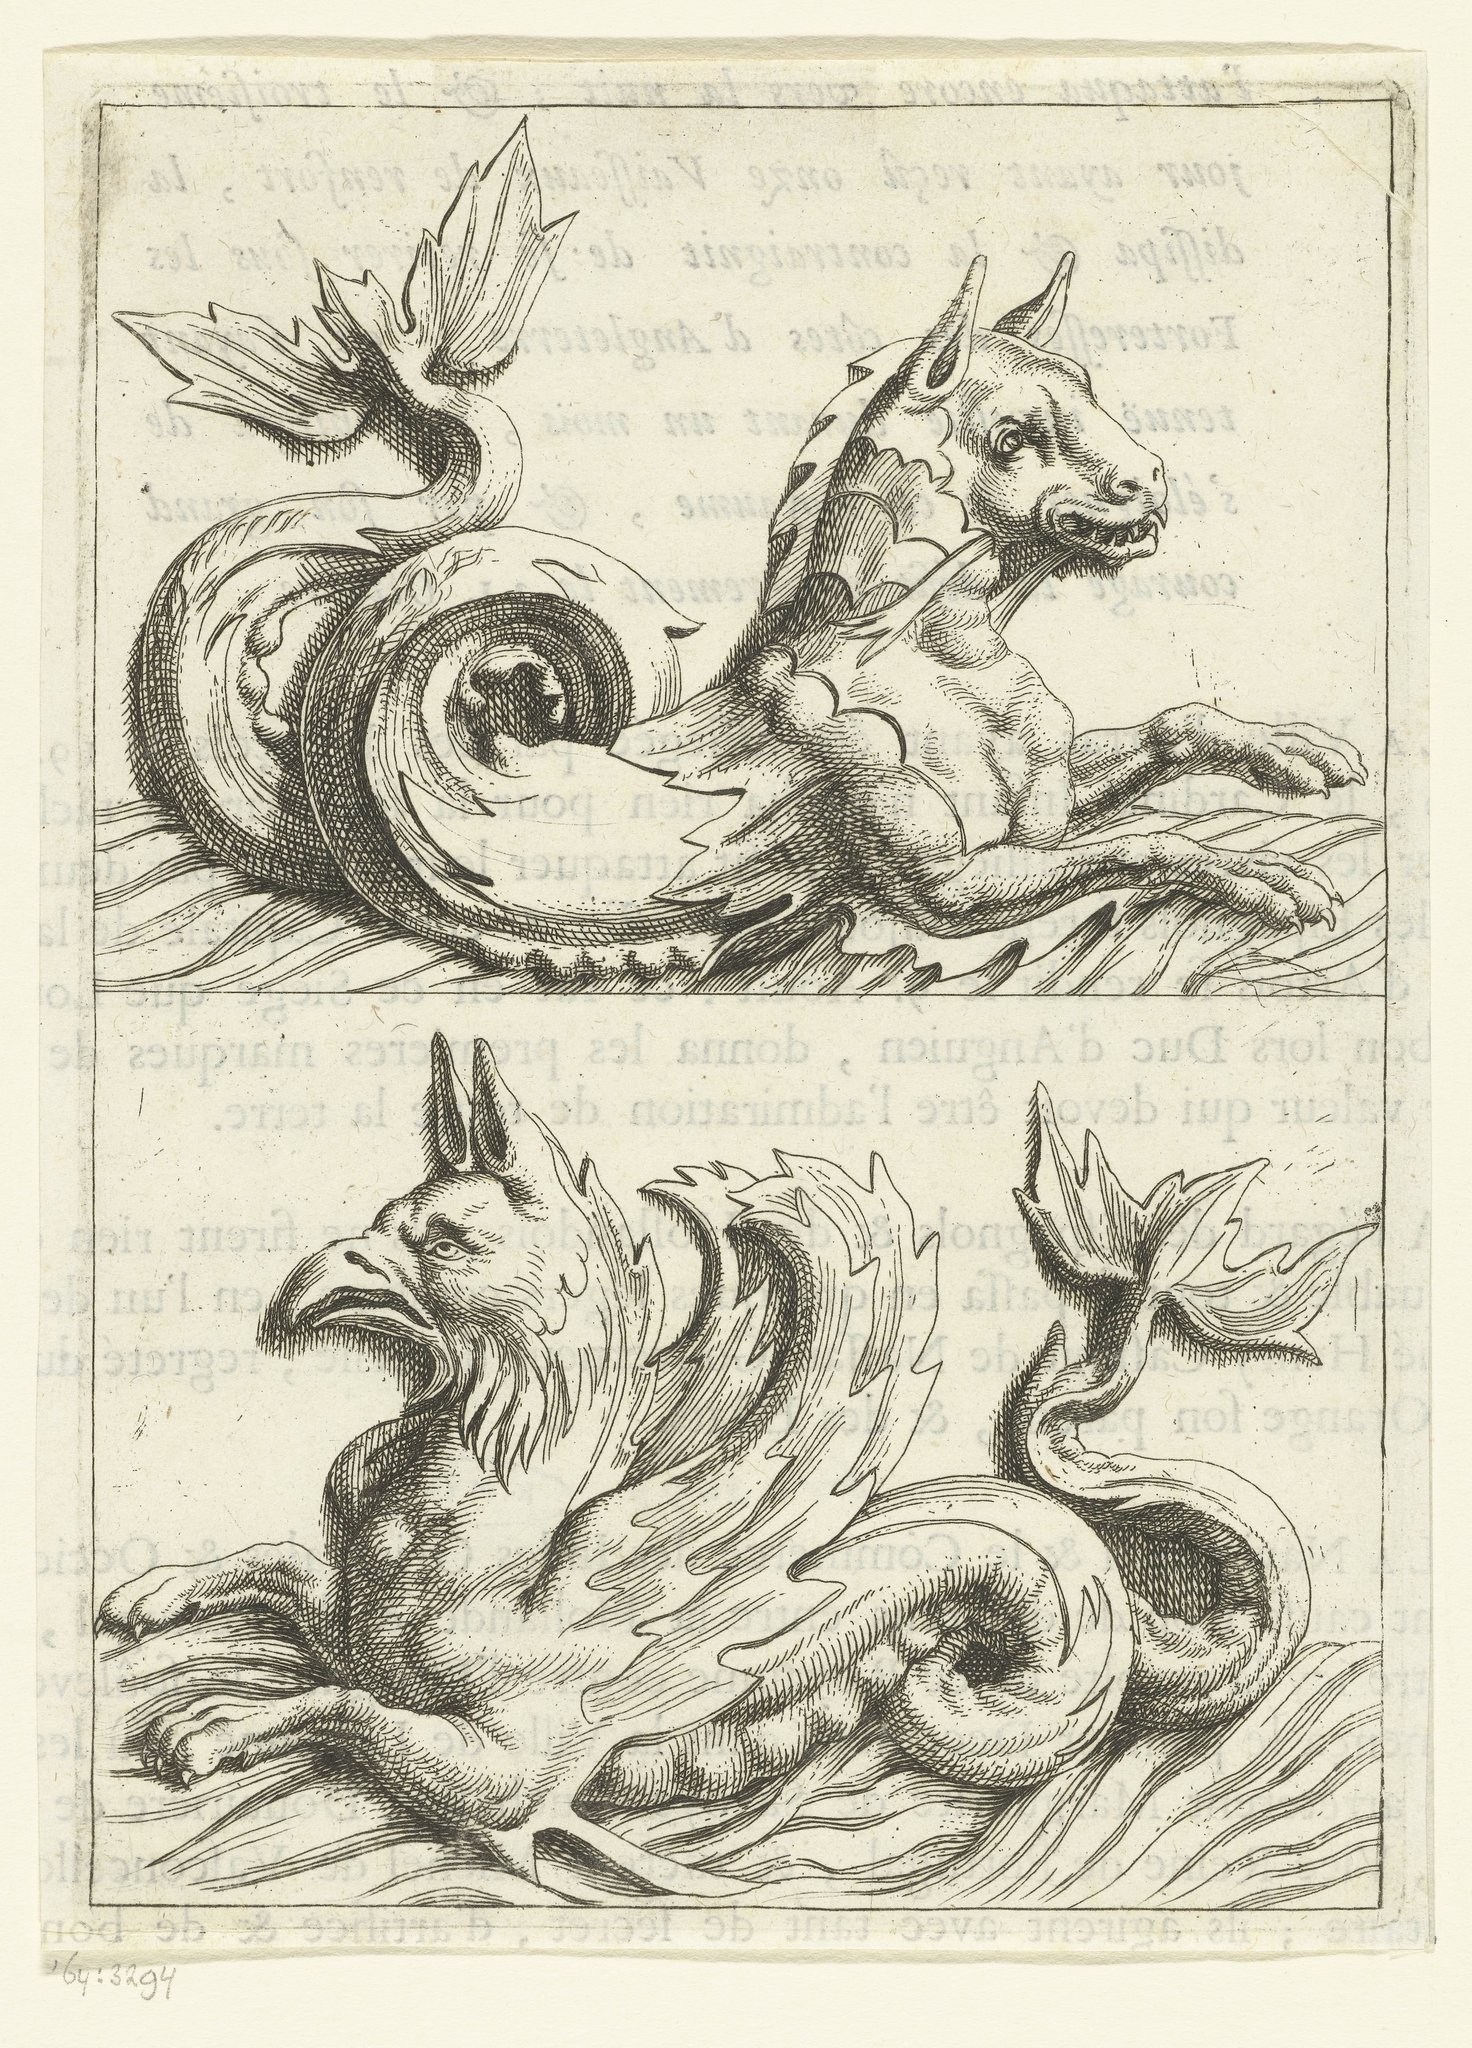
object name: print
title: Twee zeewezens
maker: Anonymous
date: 1688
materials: paper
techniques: etching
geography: netherlands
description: Twee fantasiewezens met voorpoten en een staart, het onderste heeft een snavel. Uit serie vignetten met zeegoden en allegorieën, als illustratie gebruikt in het boek Histoire metallique de la république de Hollande van P. Bizot.